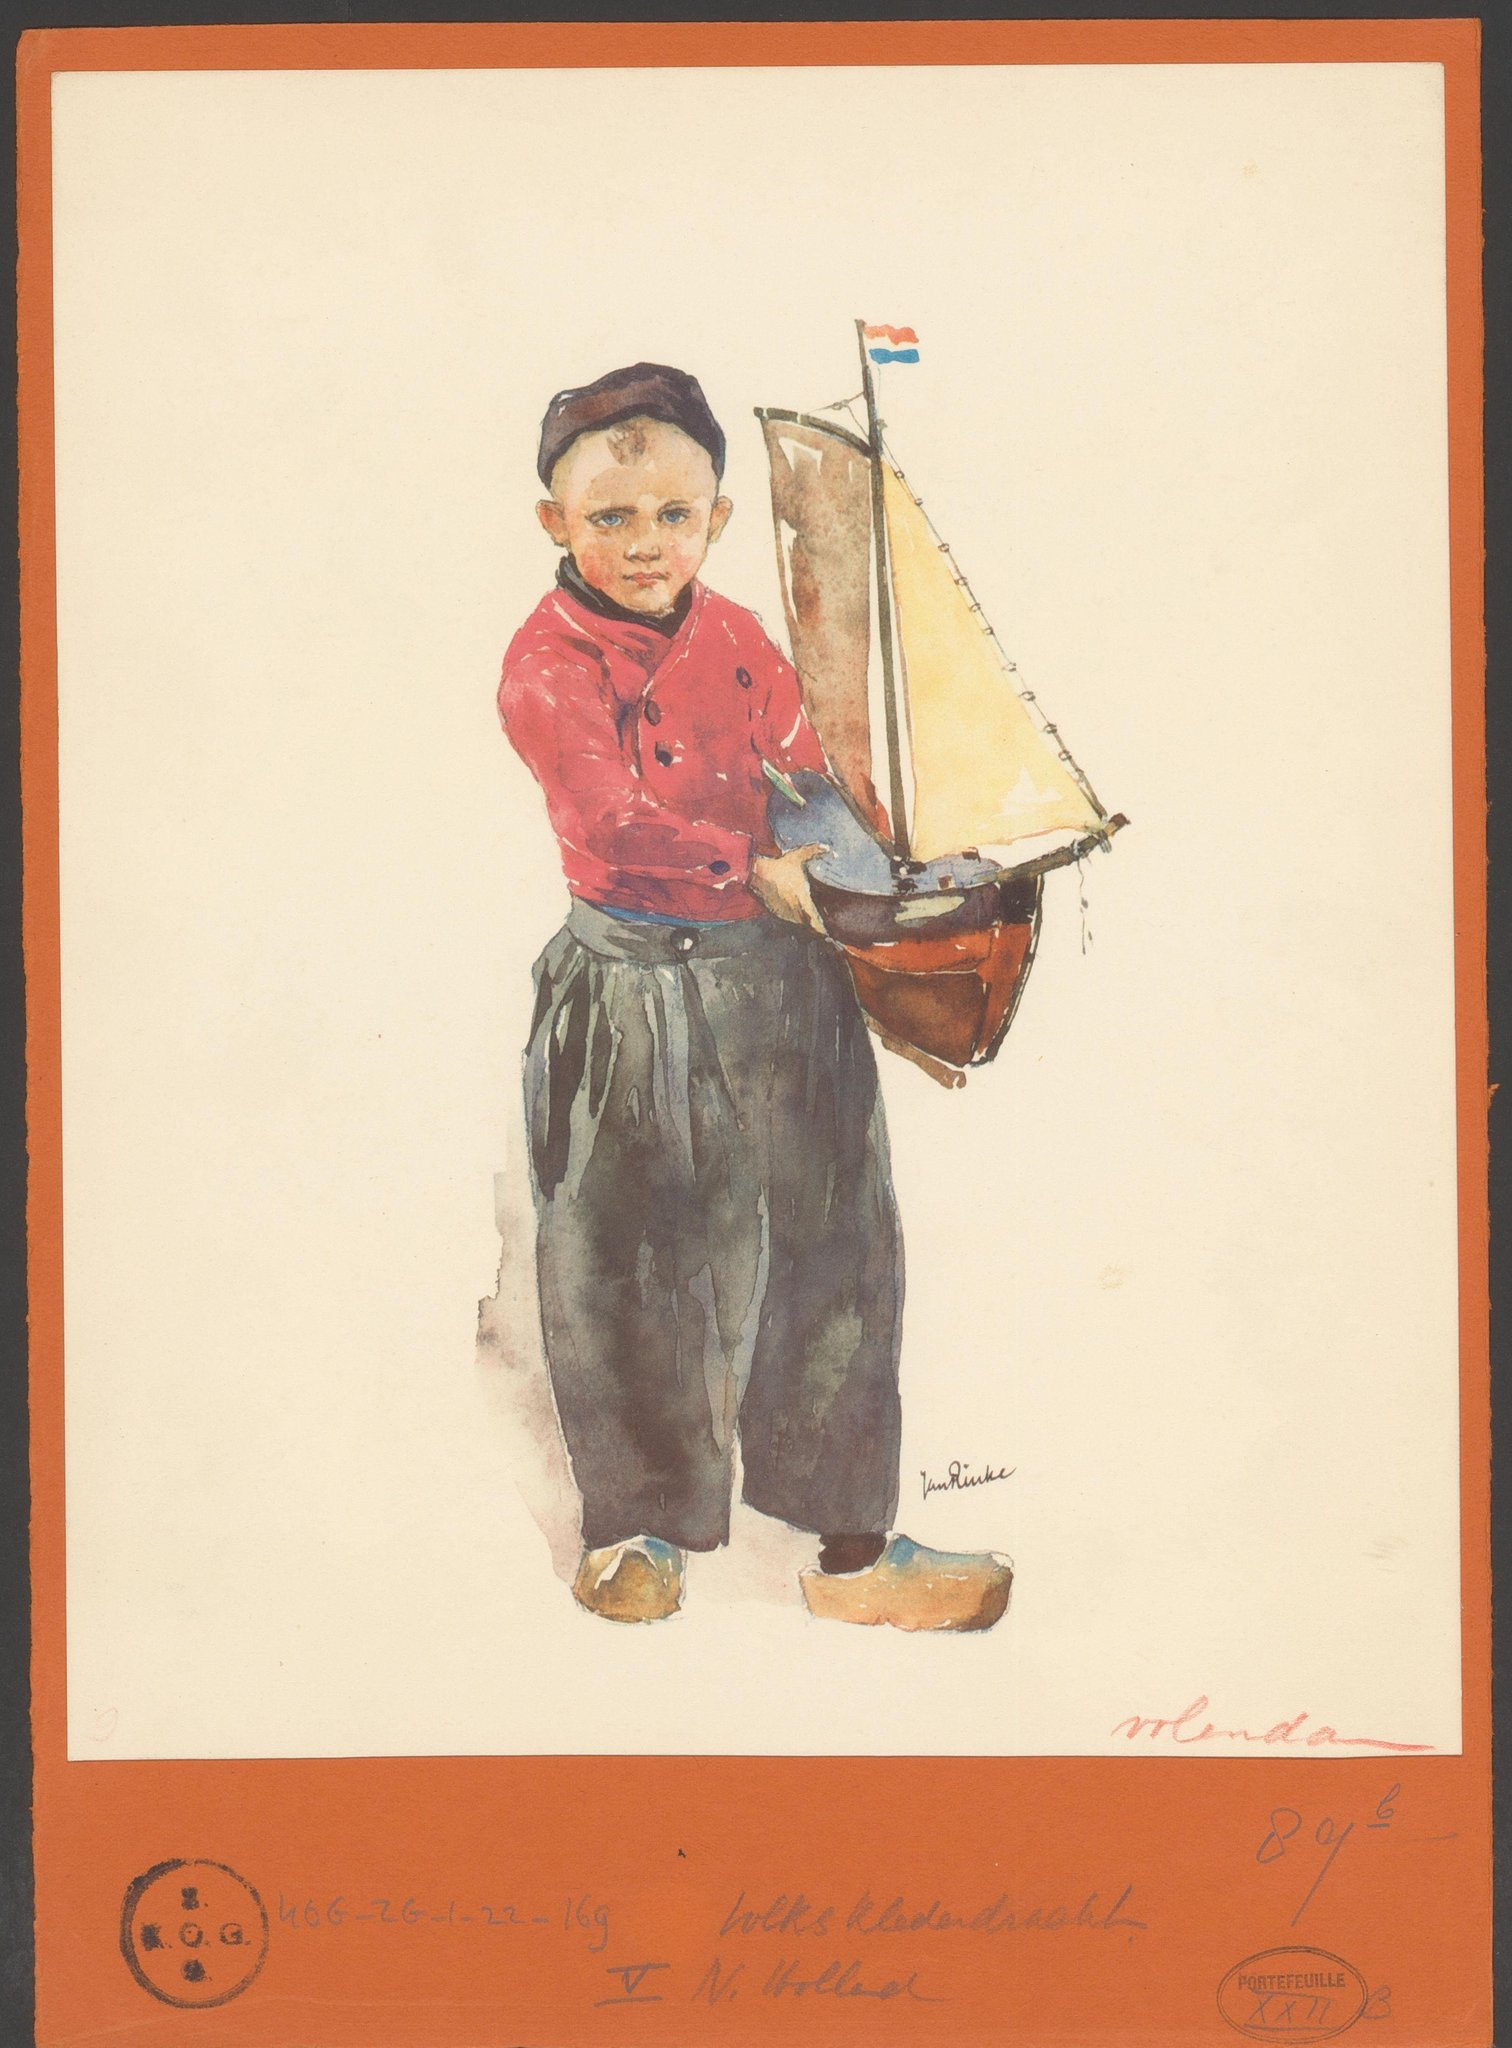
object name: photomechanical print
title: Jongen van Volendam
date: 1920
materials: paper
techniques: photograph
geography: netherlands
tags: clothes, costume (+ children's clothes), folk costume, regional costume, ship-model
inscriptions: collector's mark, collector's mark: Lugt 1641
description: Jongen in Volendamse klederdracht, staande met een scheepsmodel in de handen. Onderwerpsrubrieken binnen de Atlas Zeden en Gewoonten: De Kleeding, Volkskleederdracht, Noord-Holland.